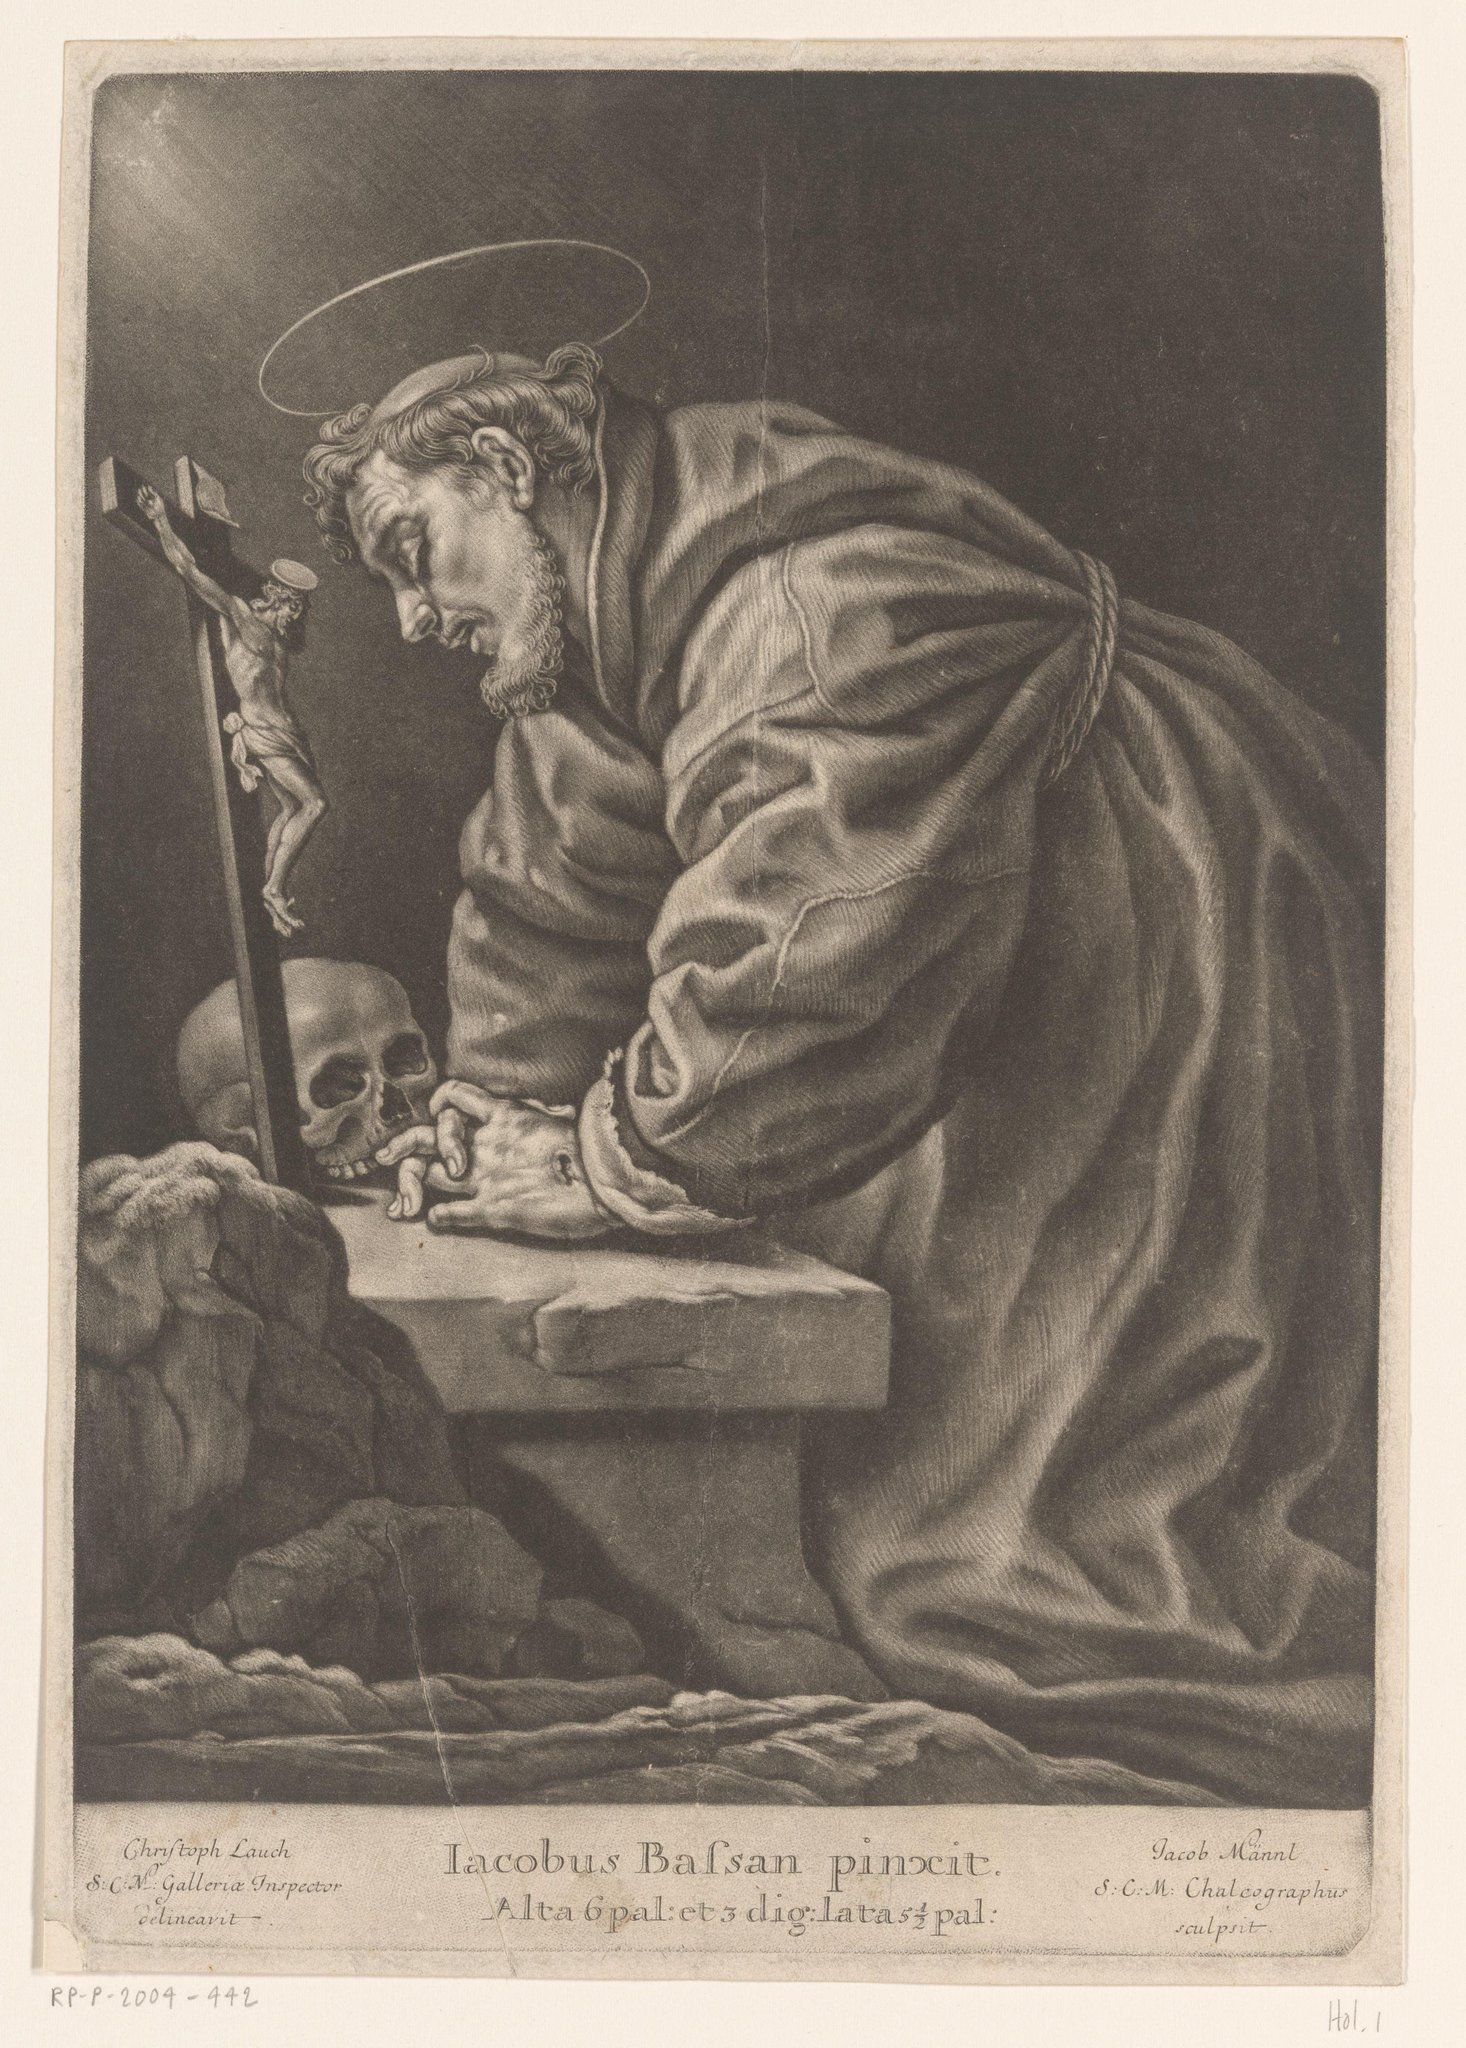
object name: print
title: Heilige Franciscus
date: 1663-1712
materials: paper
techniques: mezzotint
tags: founder of the order of friars minor (franciscans), francis(cus) of assisi; possible attributes: book, crucifix, lily, skull, stigmata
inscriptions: collector's mark: Lugt 2760, collector's mark: Lugt 2228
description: Onderdeel van een serie van 34 mezzotinten naar schilderijen in de keizerlijke galerij in Wenen.